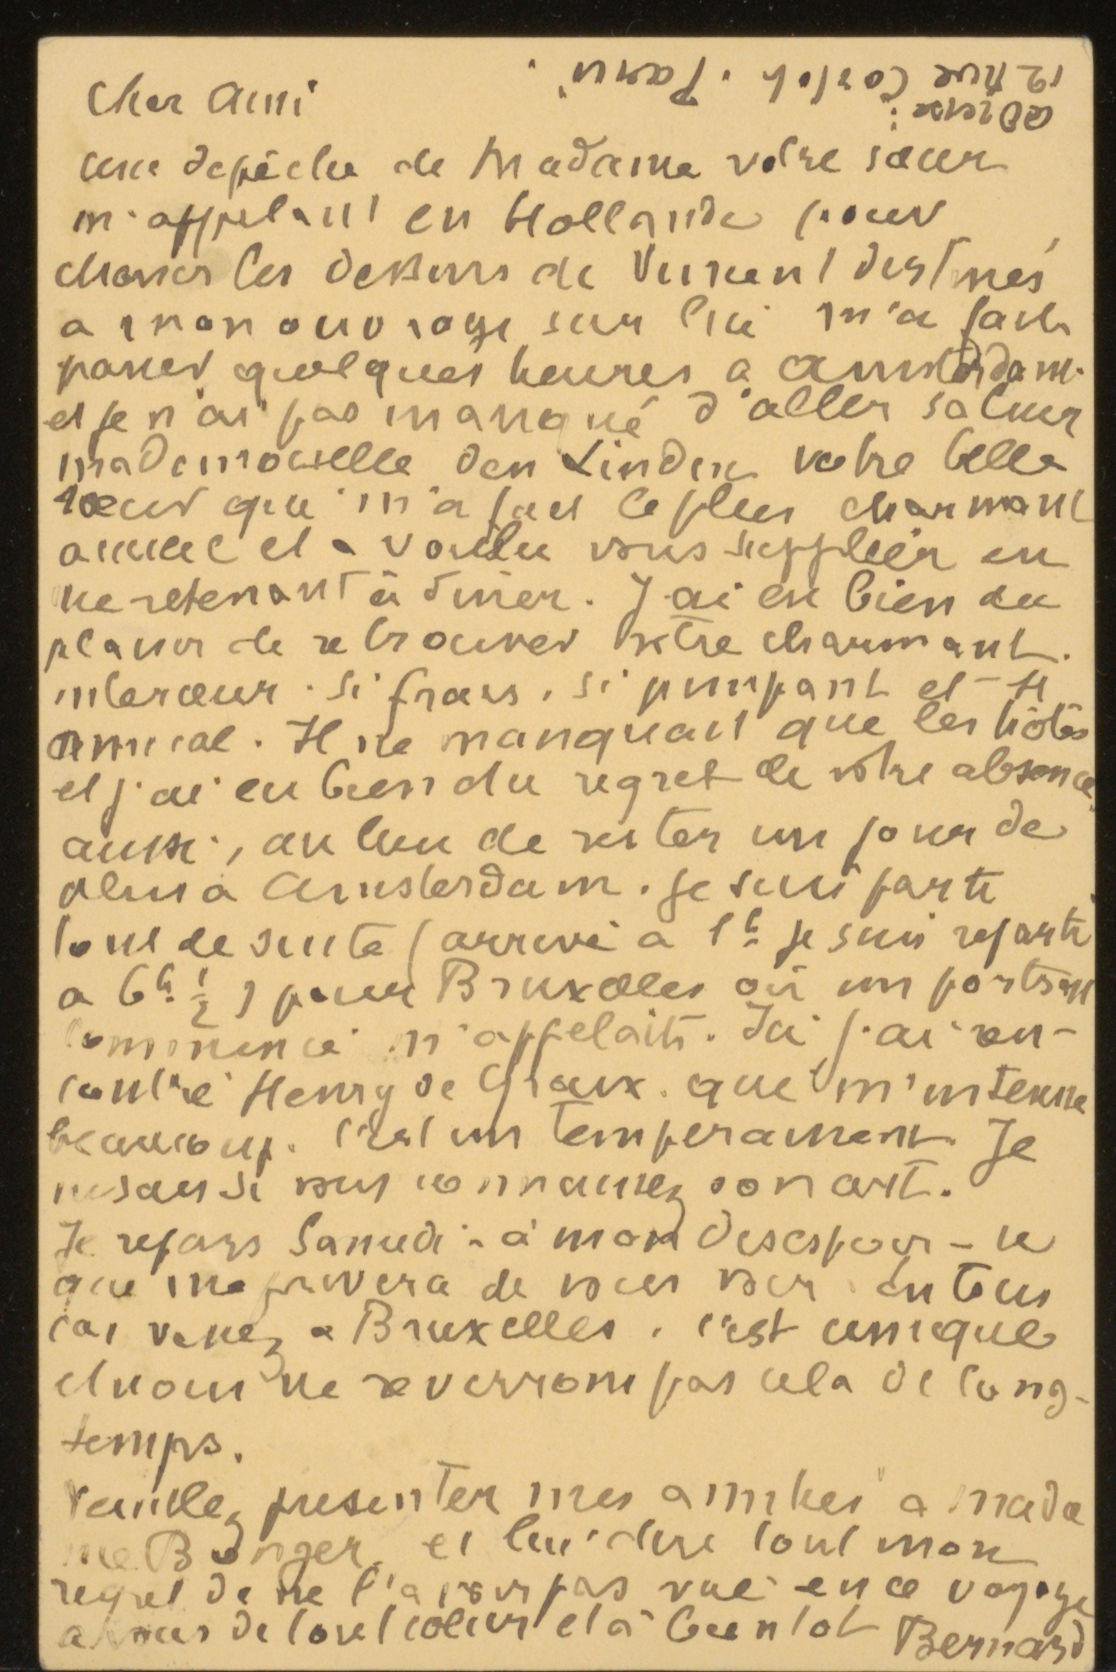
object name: postcard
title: Briefkaart aan Andries Bonger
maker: émile bernard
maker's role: print maker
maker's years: 1868-1941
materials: cardboard, ink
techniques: pen, writing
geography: sint-joost-ten-node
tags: vincent van gogh, brussels, marseille, painter, print maker, sculptor, henri de groux, andries bonger, amsterdam, johanna bonger, drawing